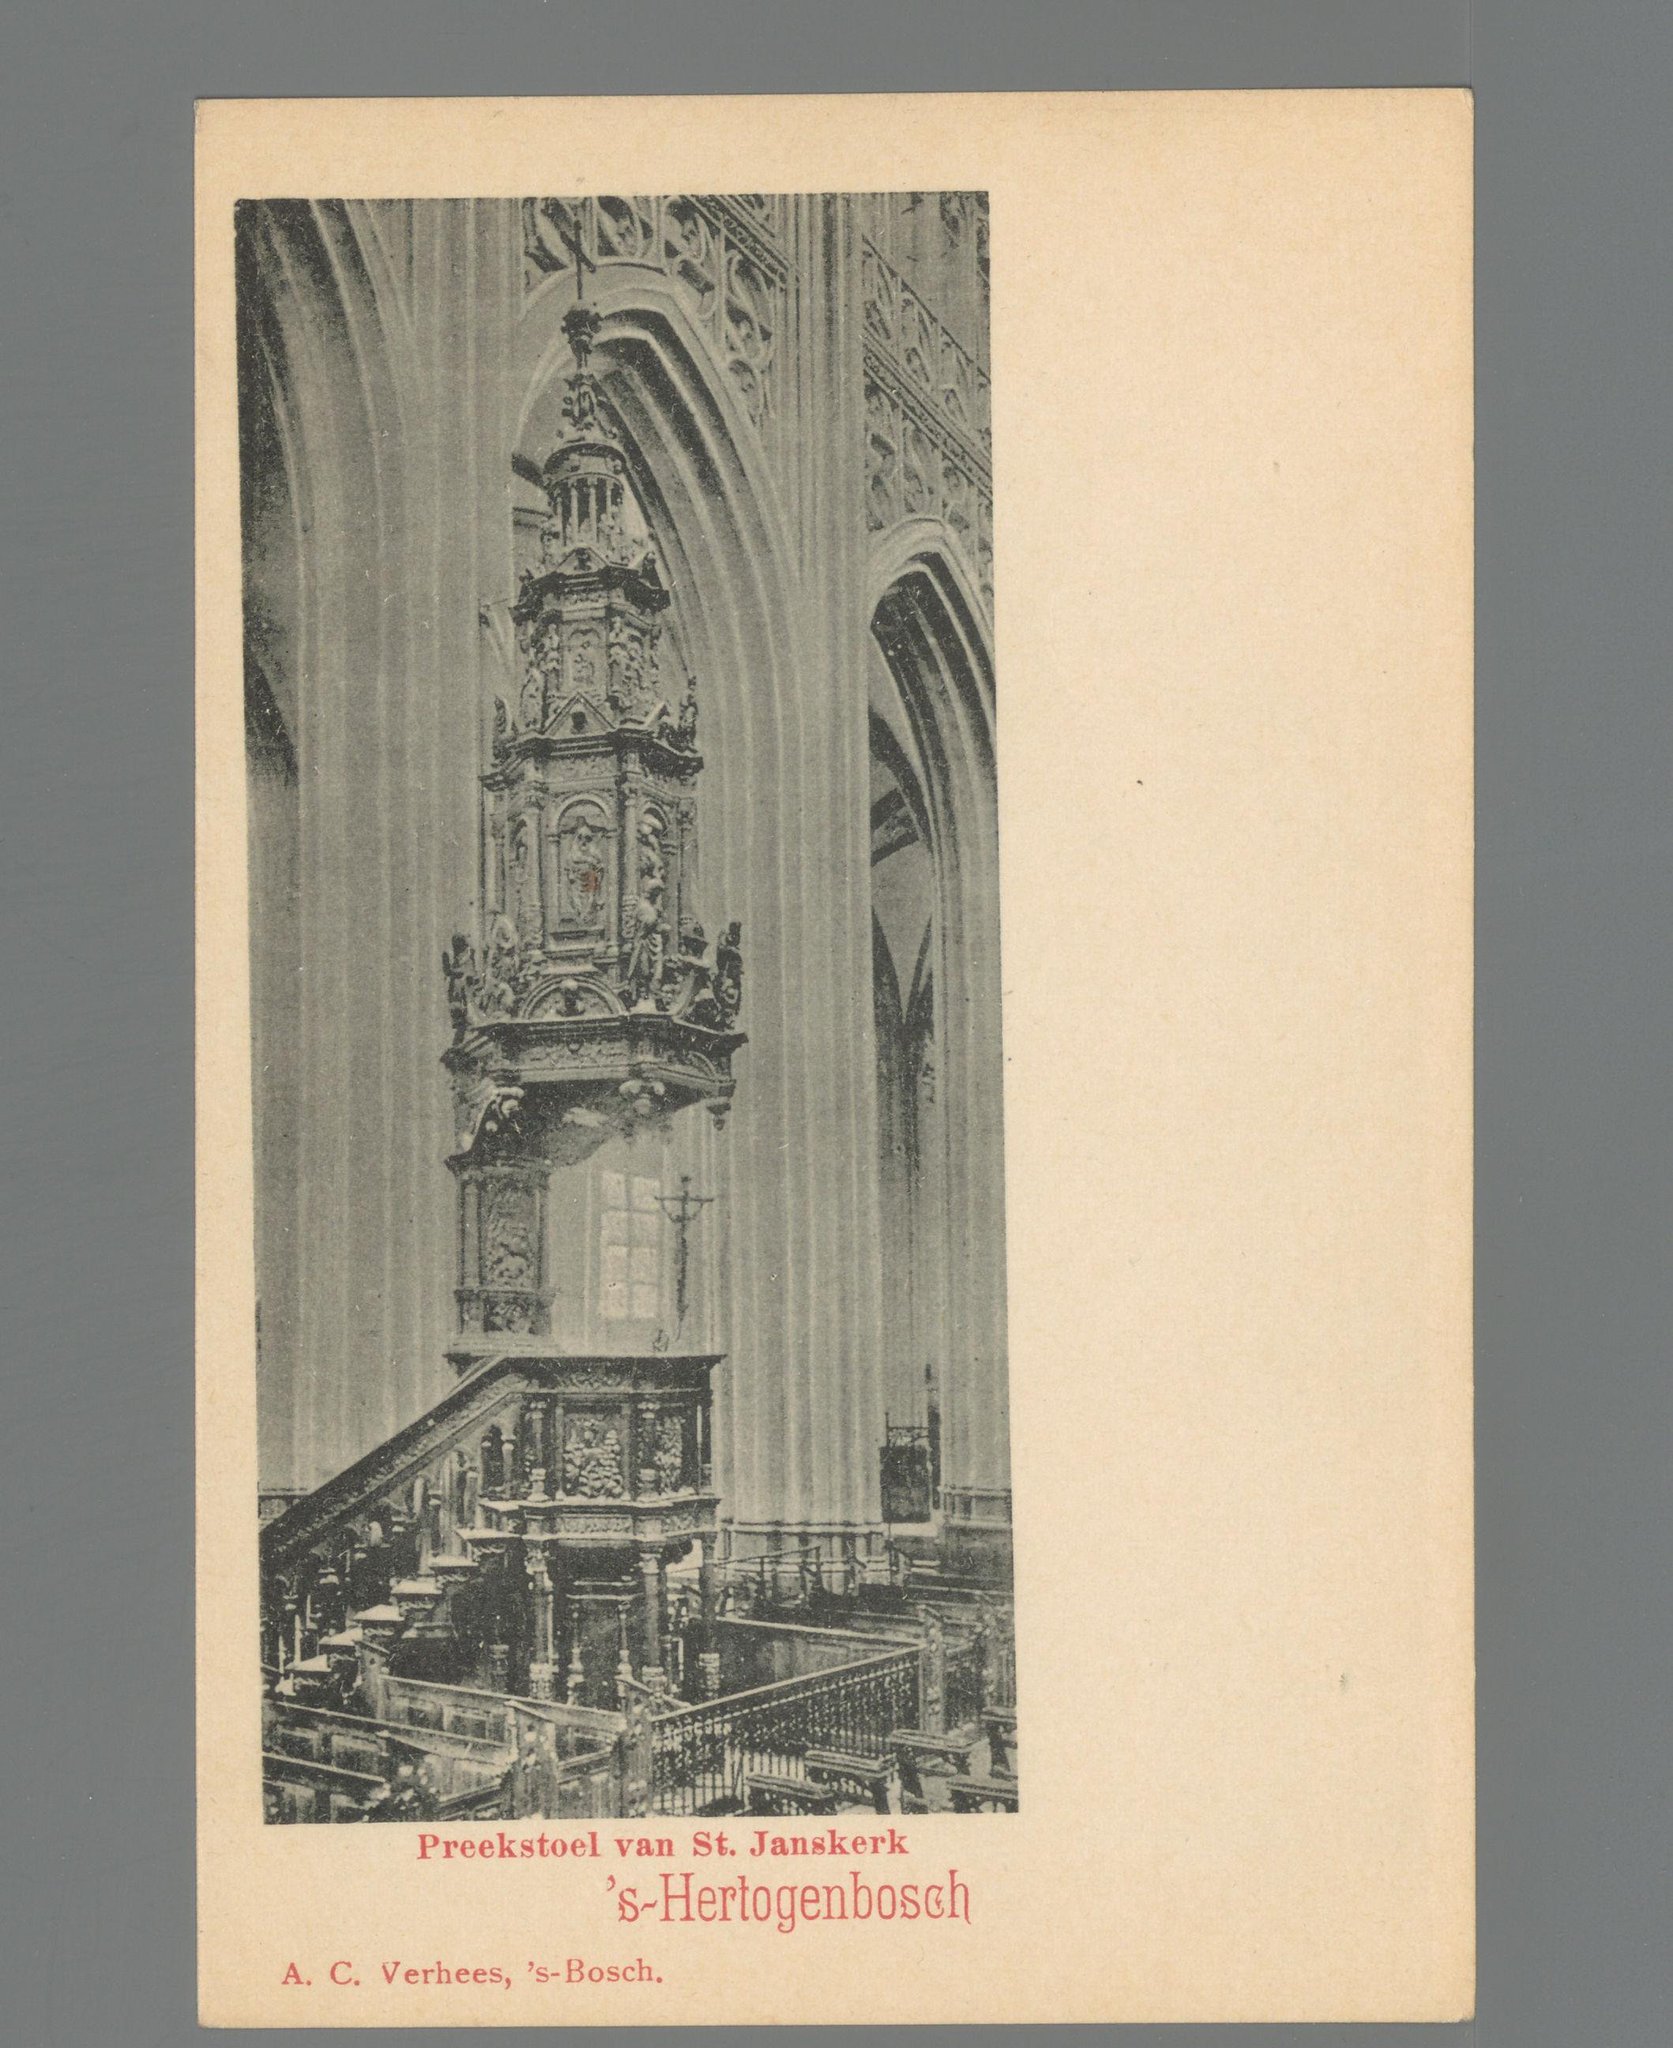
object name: photomechanical print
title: Preekstoel van St. Janskerk. 's-Hertogenbosch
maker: Anonymous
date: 1892-1905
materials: cardboard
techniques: photograph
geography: den bosch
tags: interior of church, pulpit, ambo, chancel